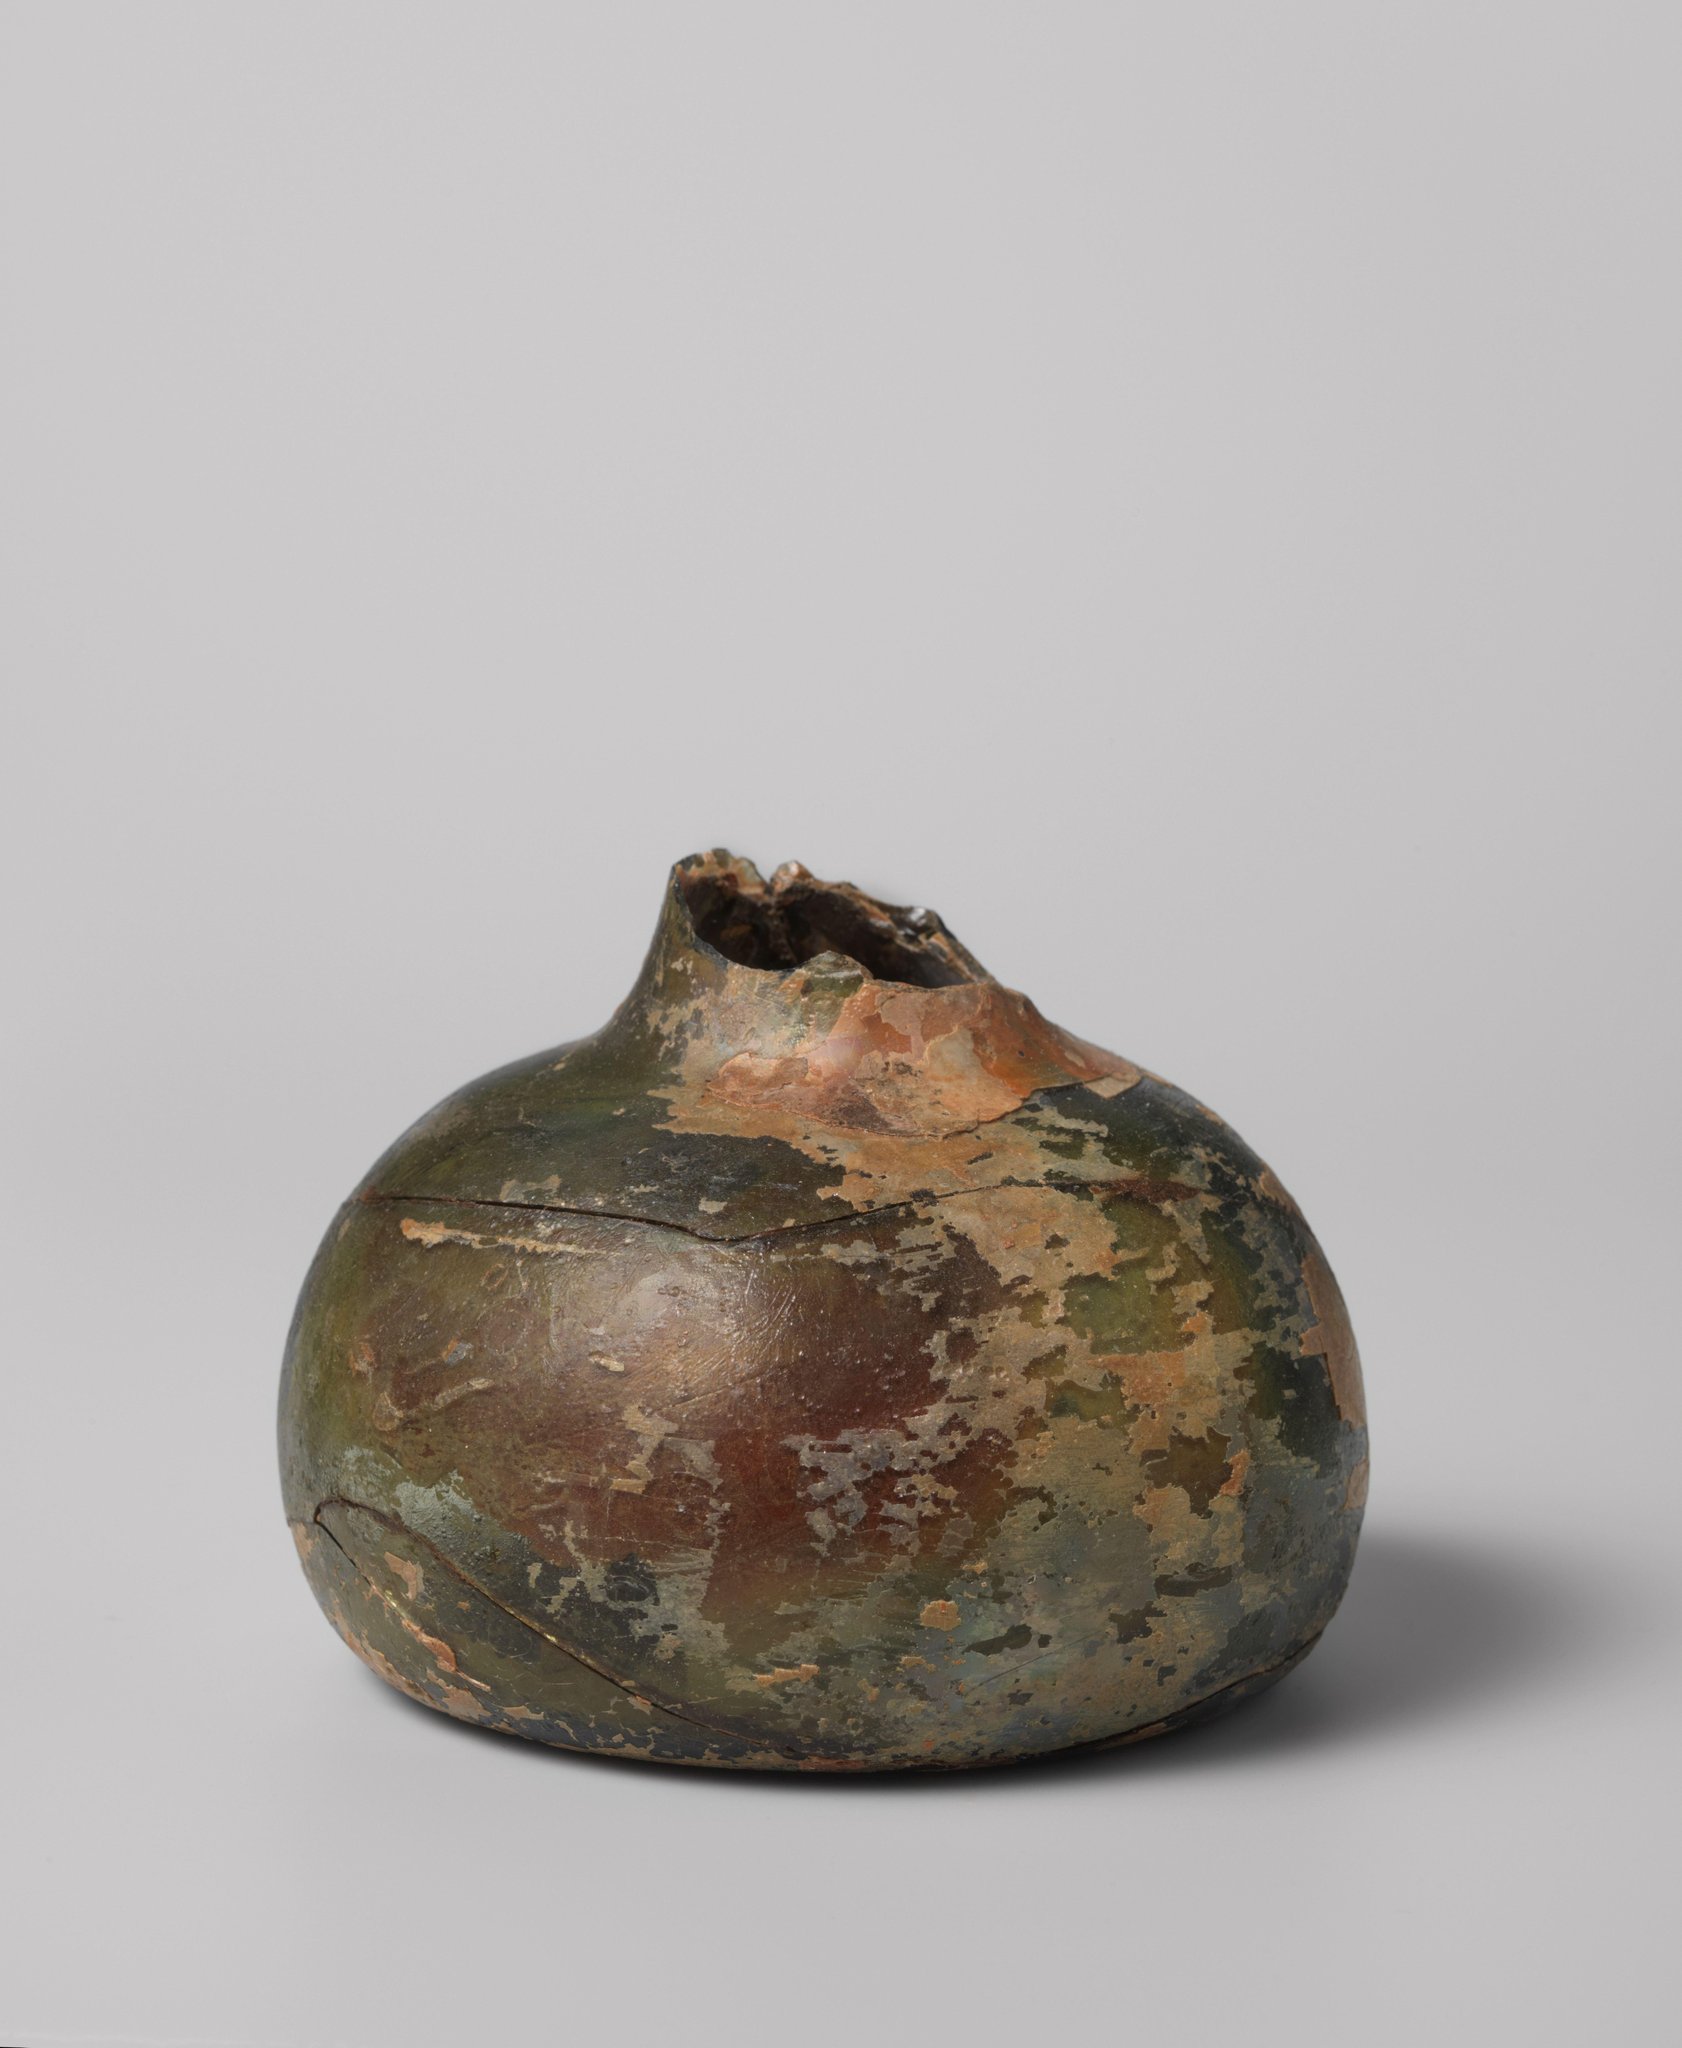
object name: wine bottle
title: Wijnfles uit het wrak van de Oost-Indiëvaarder Hollandia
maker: Anonymous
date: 1700-1743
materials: glass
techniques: green glass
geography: netherlands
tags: verenigde oostindische compagnie, hollandia (schip), annet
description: Incomplete wijnfles. Wine bottle, continental production, onion-shaped, mouth missing; (1) eroded (10.5h, belly 14.5d, base 10.7d), tcs-kick-up.